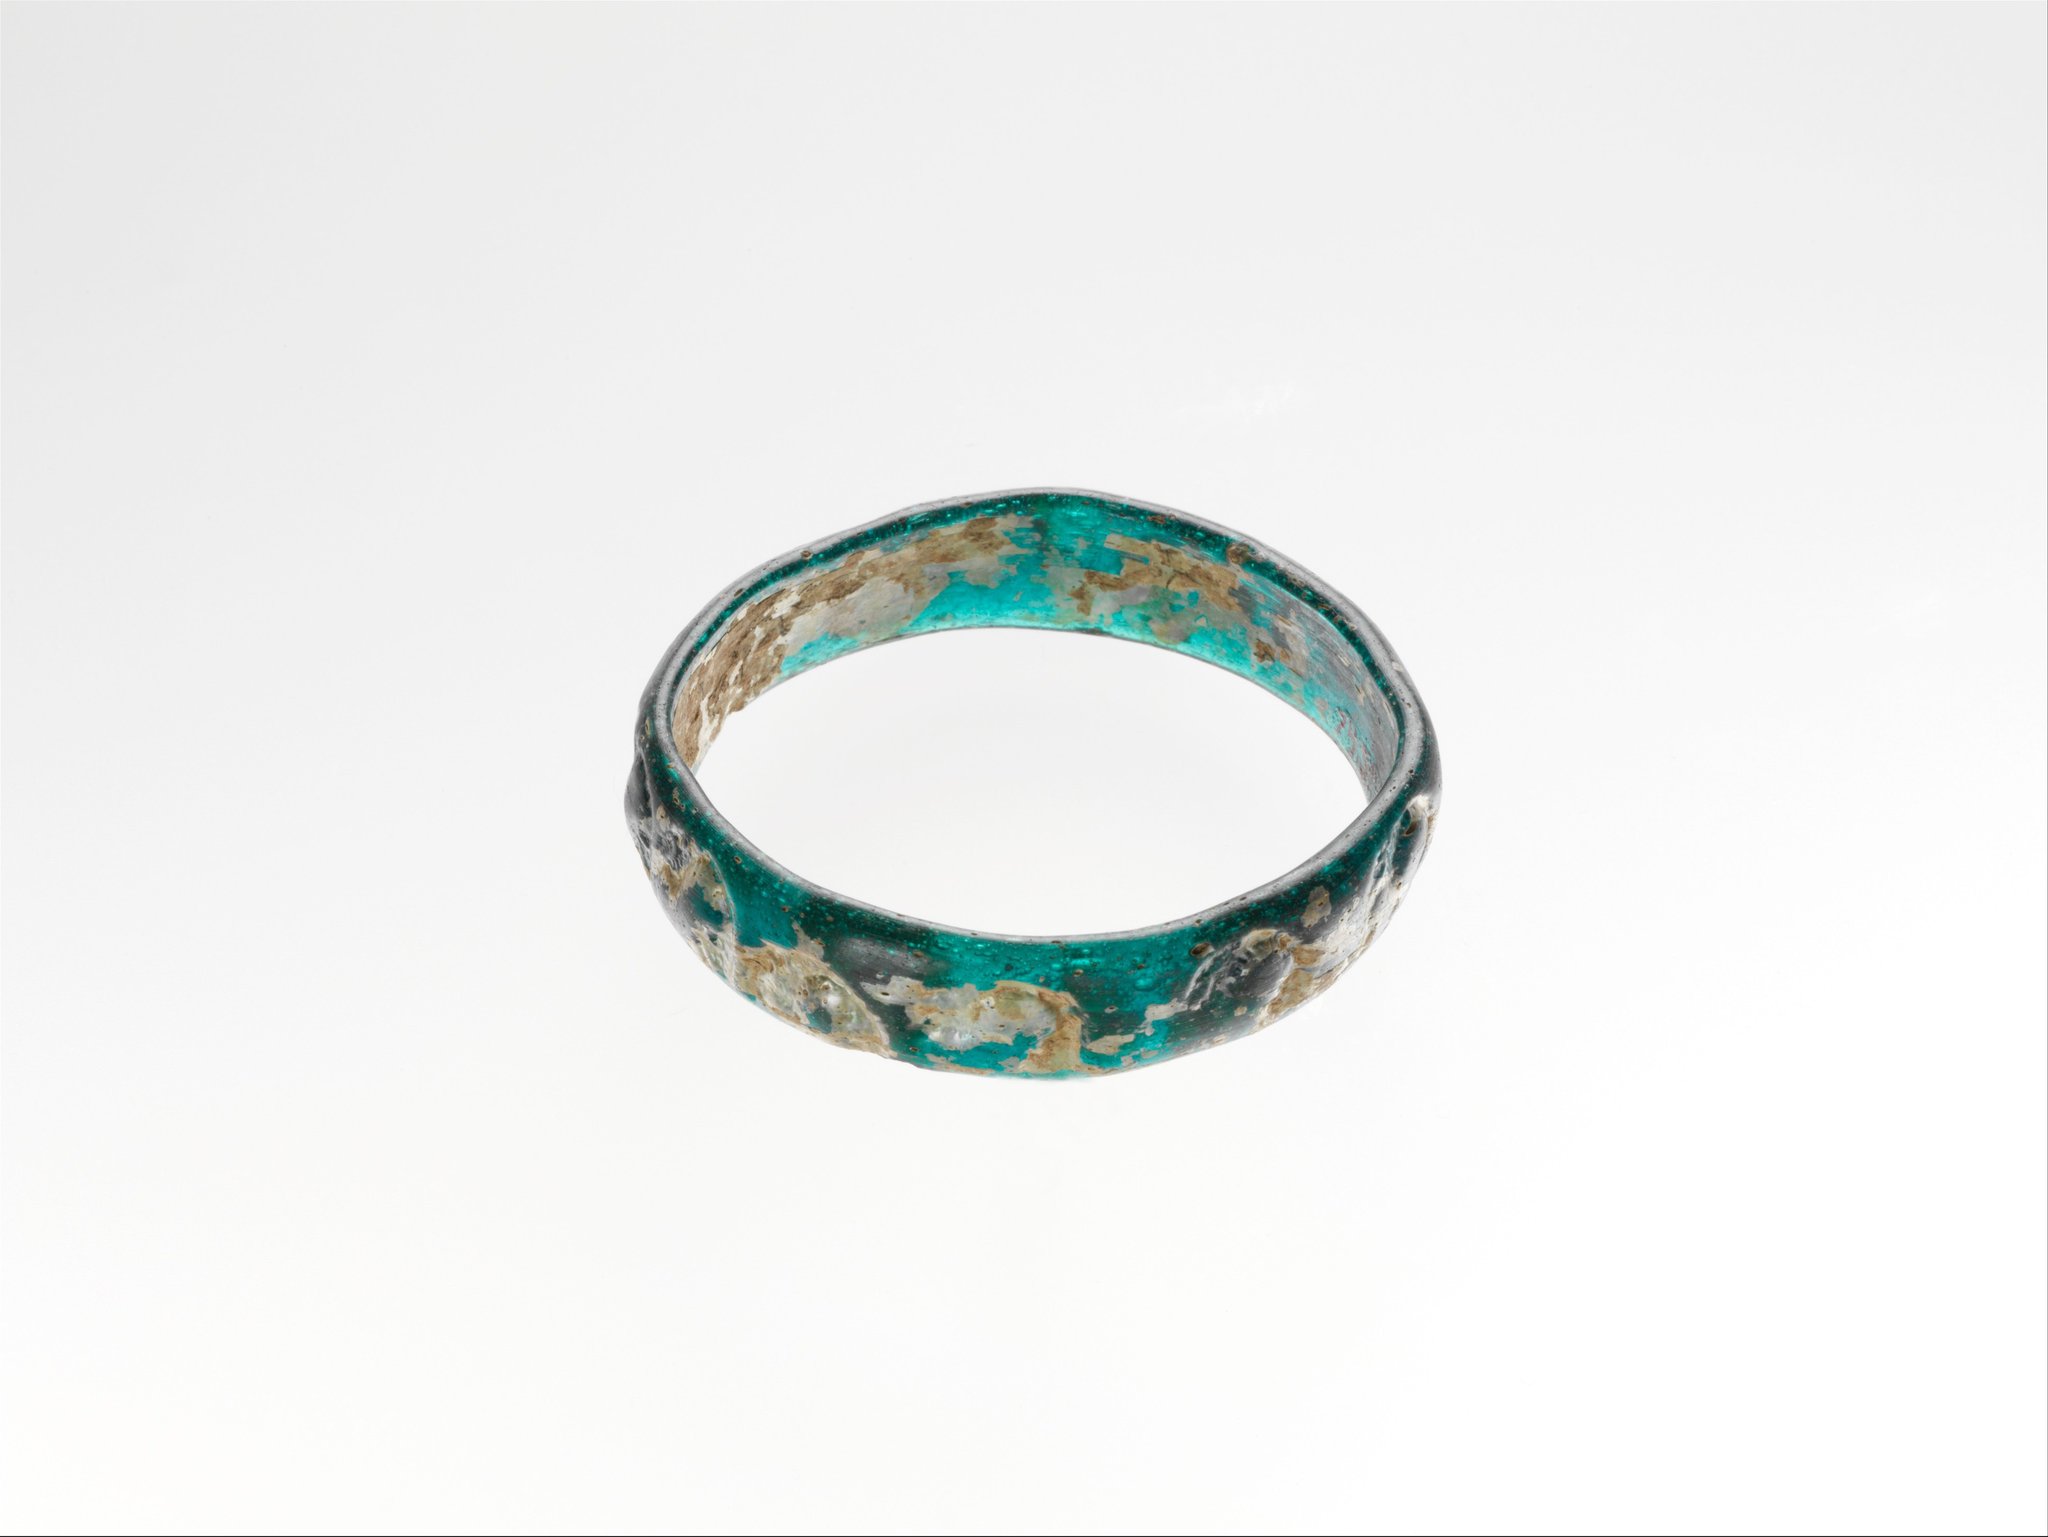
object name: bracelet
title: Glass bracelet with impressed decoration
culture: roman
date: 367-500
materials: glass